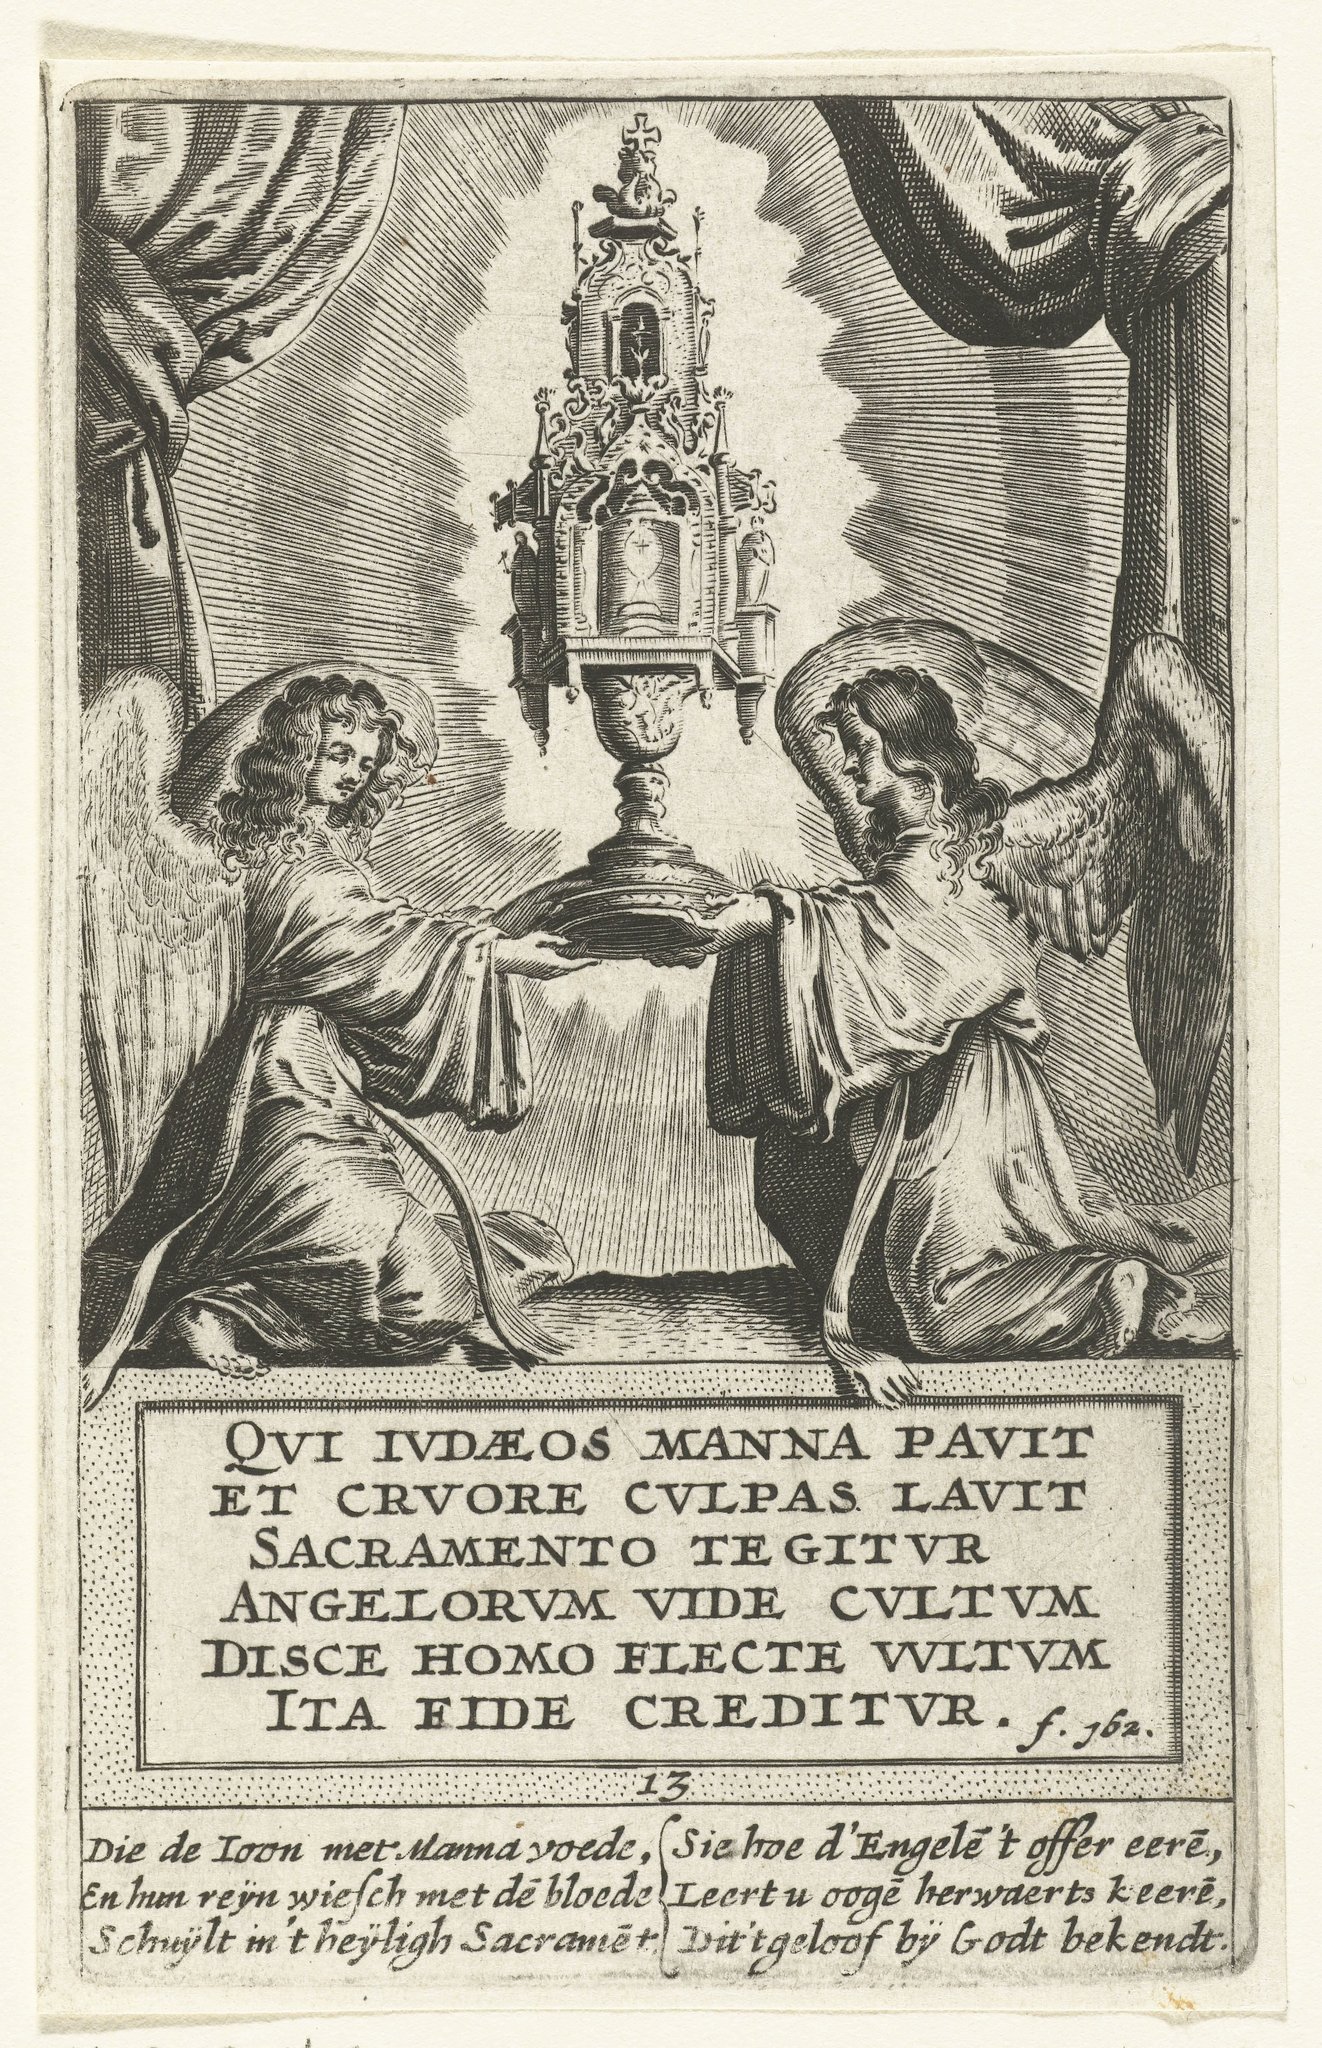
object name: book illustration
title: Twee engelen met de monstrans met het heilig Sacrament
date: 1590-1633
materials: paper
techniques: engraving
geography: low countries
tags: ostensorium, monstrance, adoration of the host, e.g. perpetual adoration, angels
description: Prent uit: Leonardus Marius, Amstelredams eer ende opcomen, door de denckwaerdighe miraklen aldaer geschied aen ende door het H. Sacrament des Altaers Anno 1345, Antwerpen, Hendrick Aertssens, 1639, afb. 13